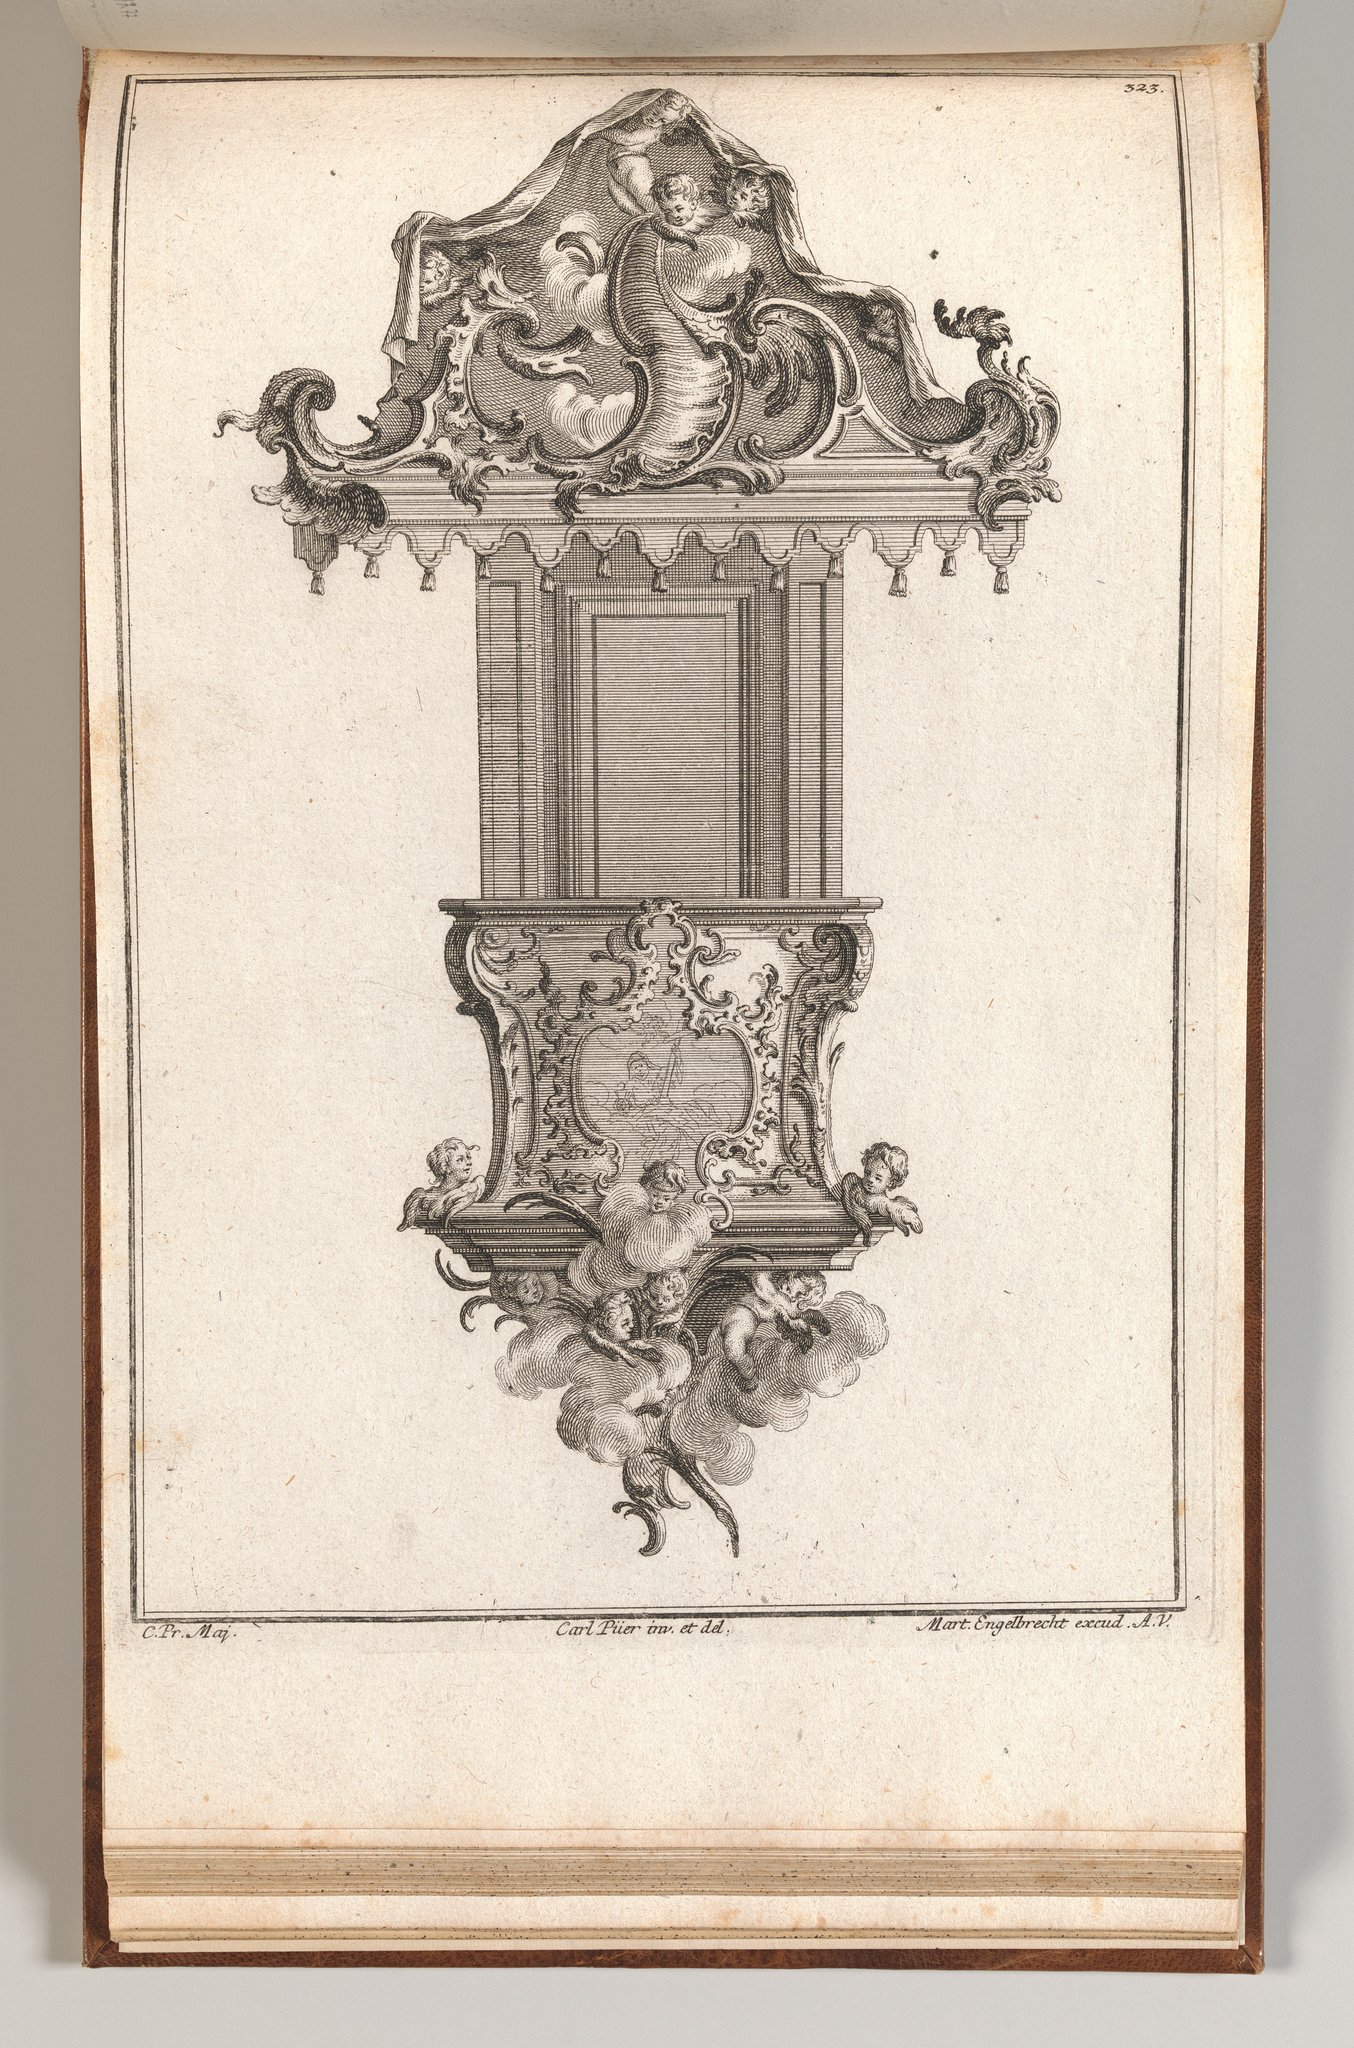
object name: album print ornament architecture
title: Design for a Pulpit, Plate 2 from an Untitled Series of Pulpit Designs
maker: carl pier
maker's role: artist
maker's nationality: german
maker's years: 1700-1790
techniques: etching